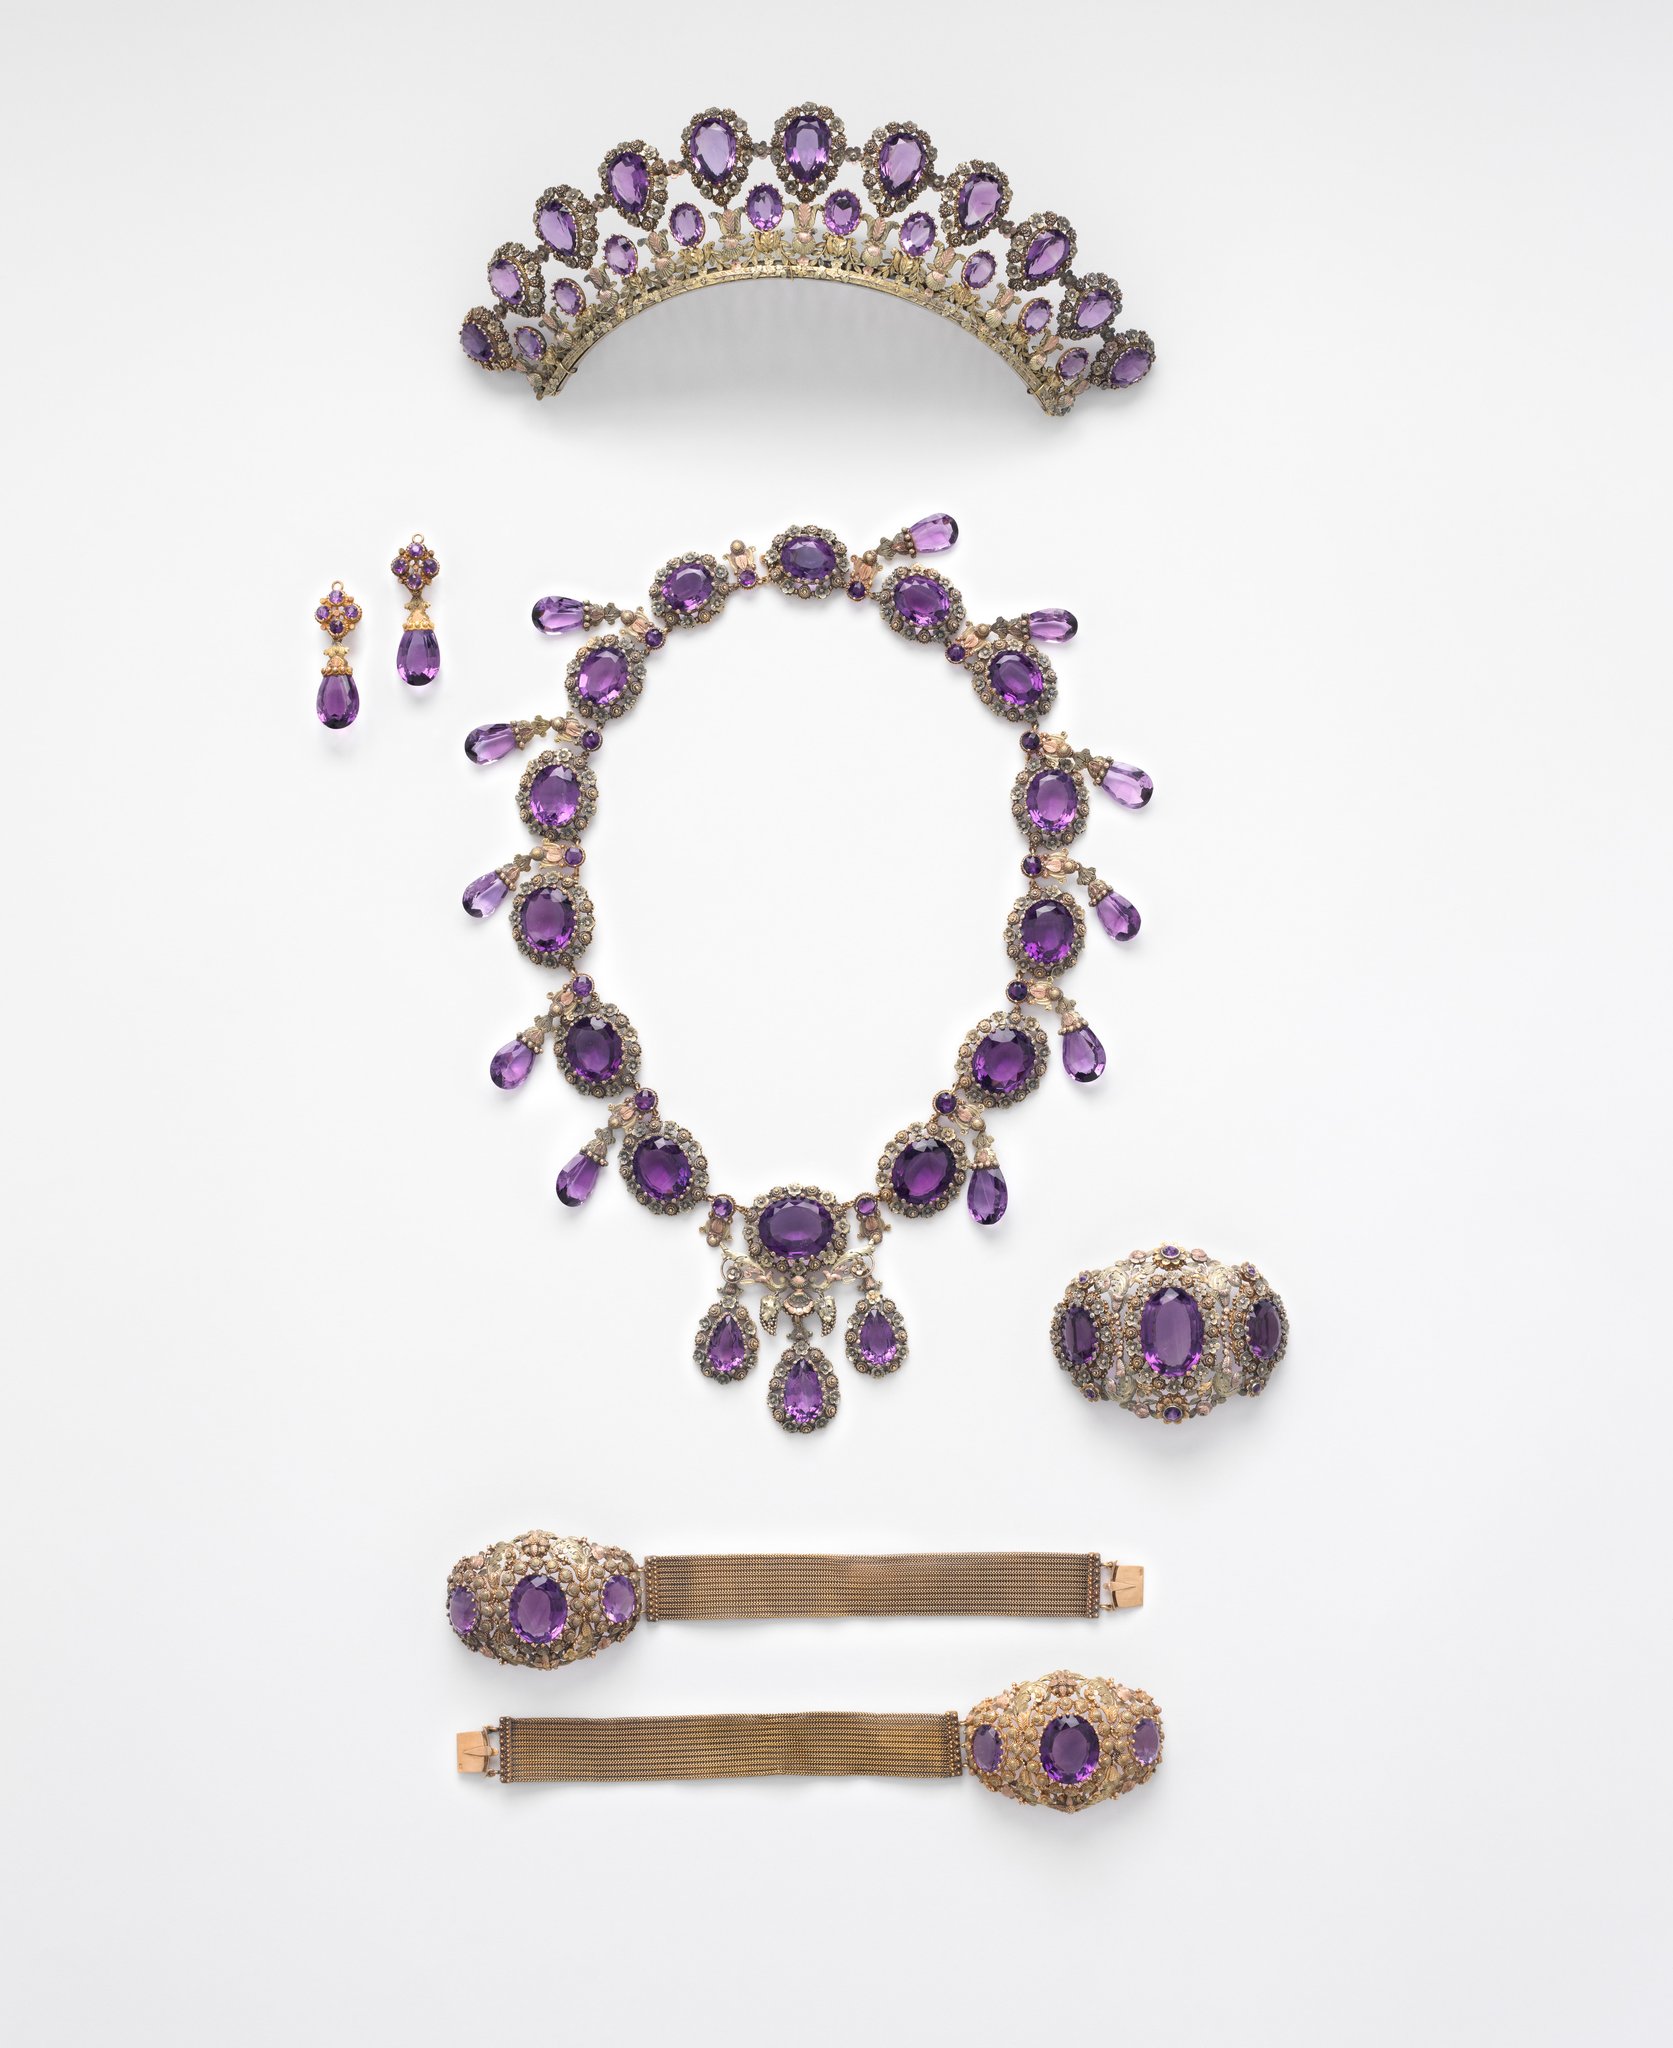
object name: necklace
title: Necklace (part of a set)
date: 1830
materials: amethyst, gold